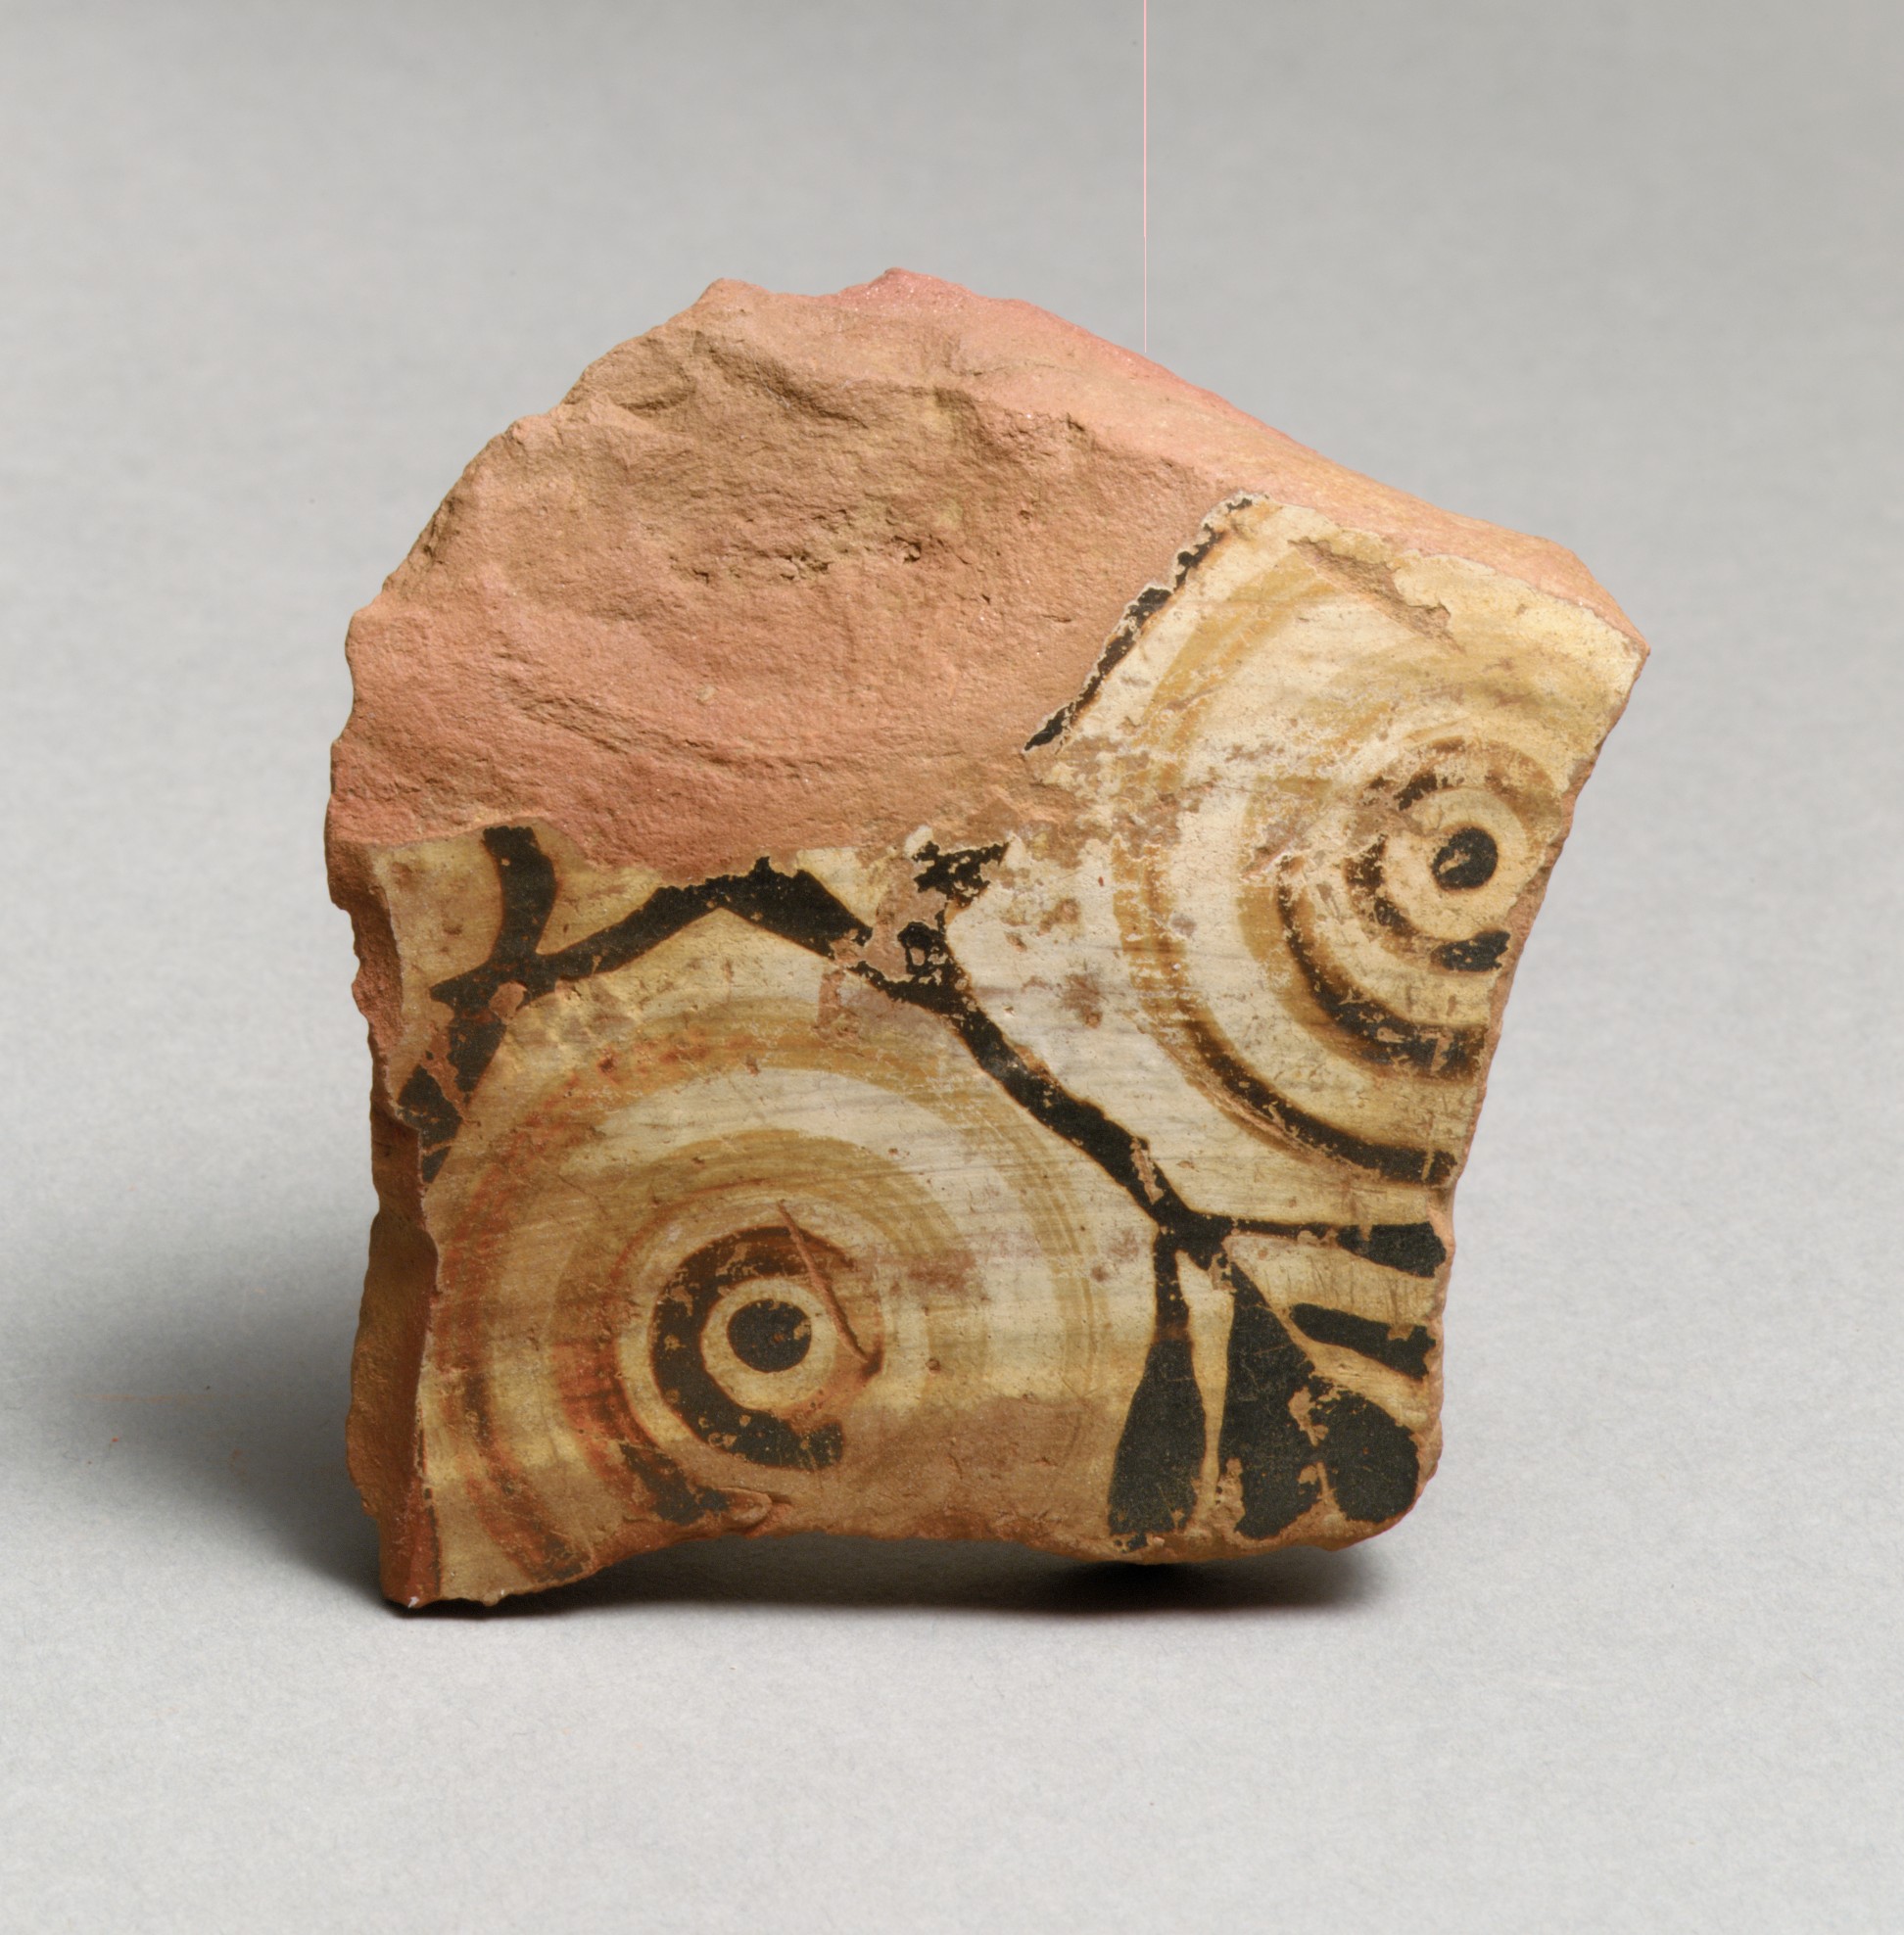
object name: vase fragment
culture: greek or lydian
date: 900-30 BCE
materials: terracotta